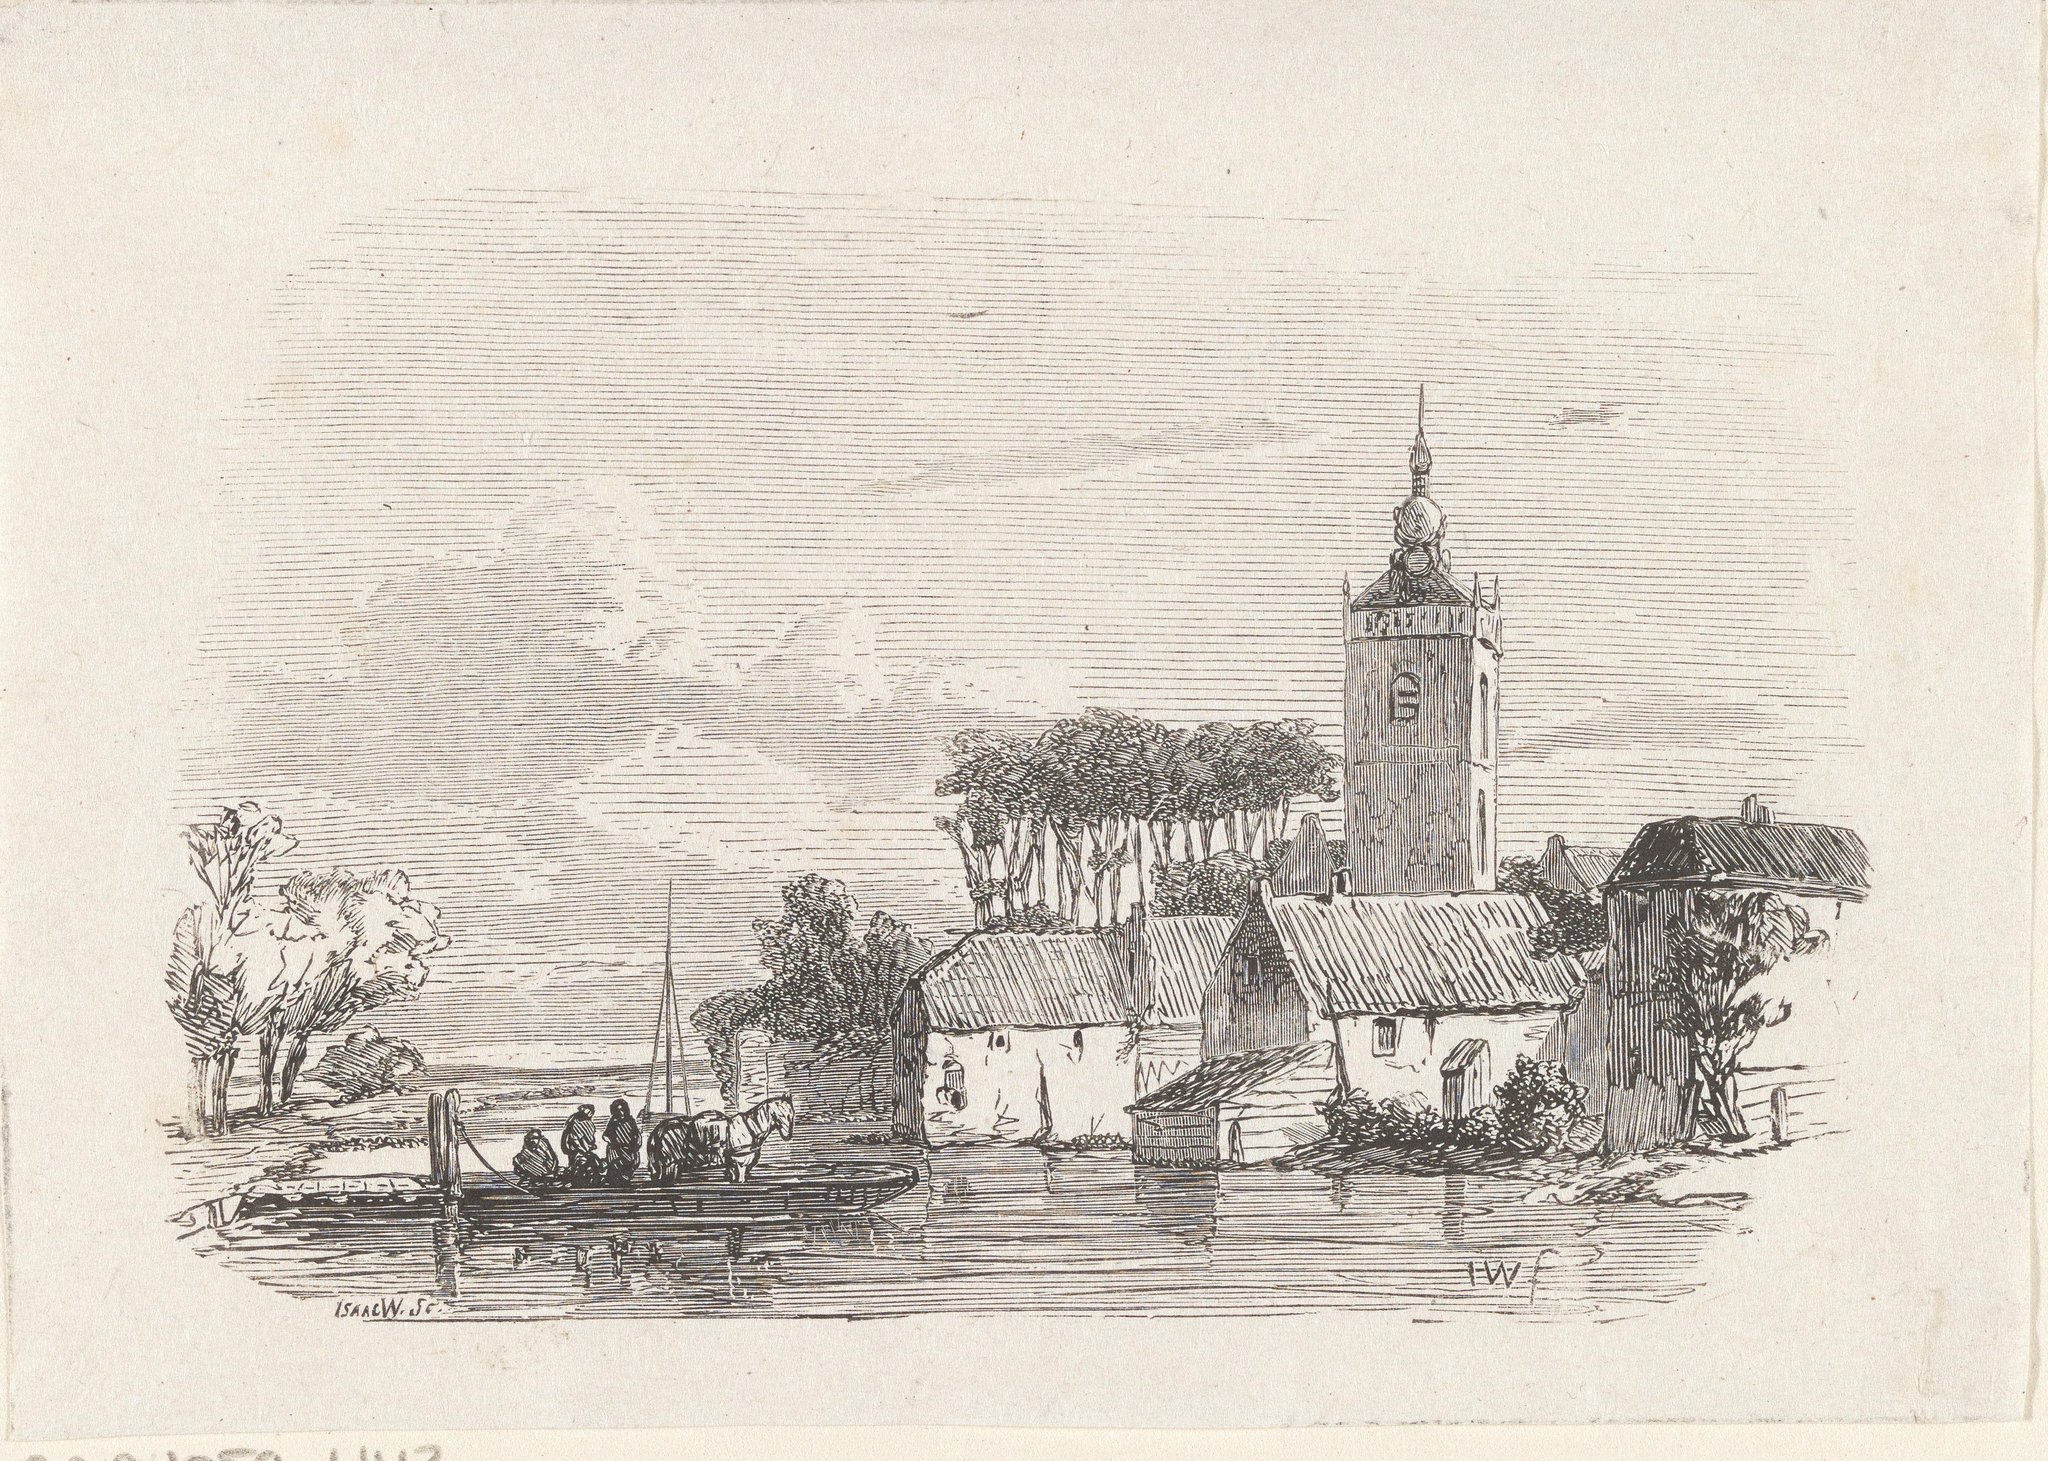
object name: print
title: Gezicht op Overschie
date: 1836-1912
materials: paper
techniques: engraving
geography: netherlands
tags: city-view, and landscape with man-made constructions (+ city(-scape) with figures, staffage), overschie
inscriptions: collector's mark: Lugt 2228